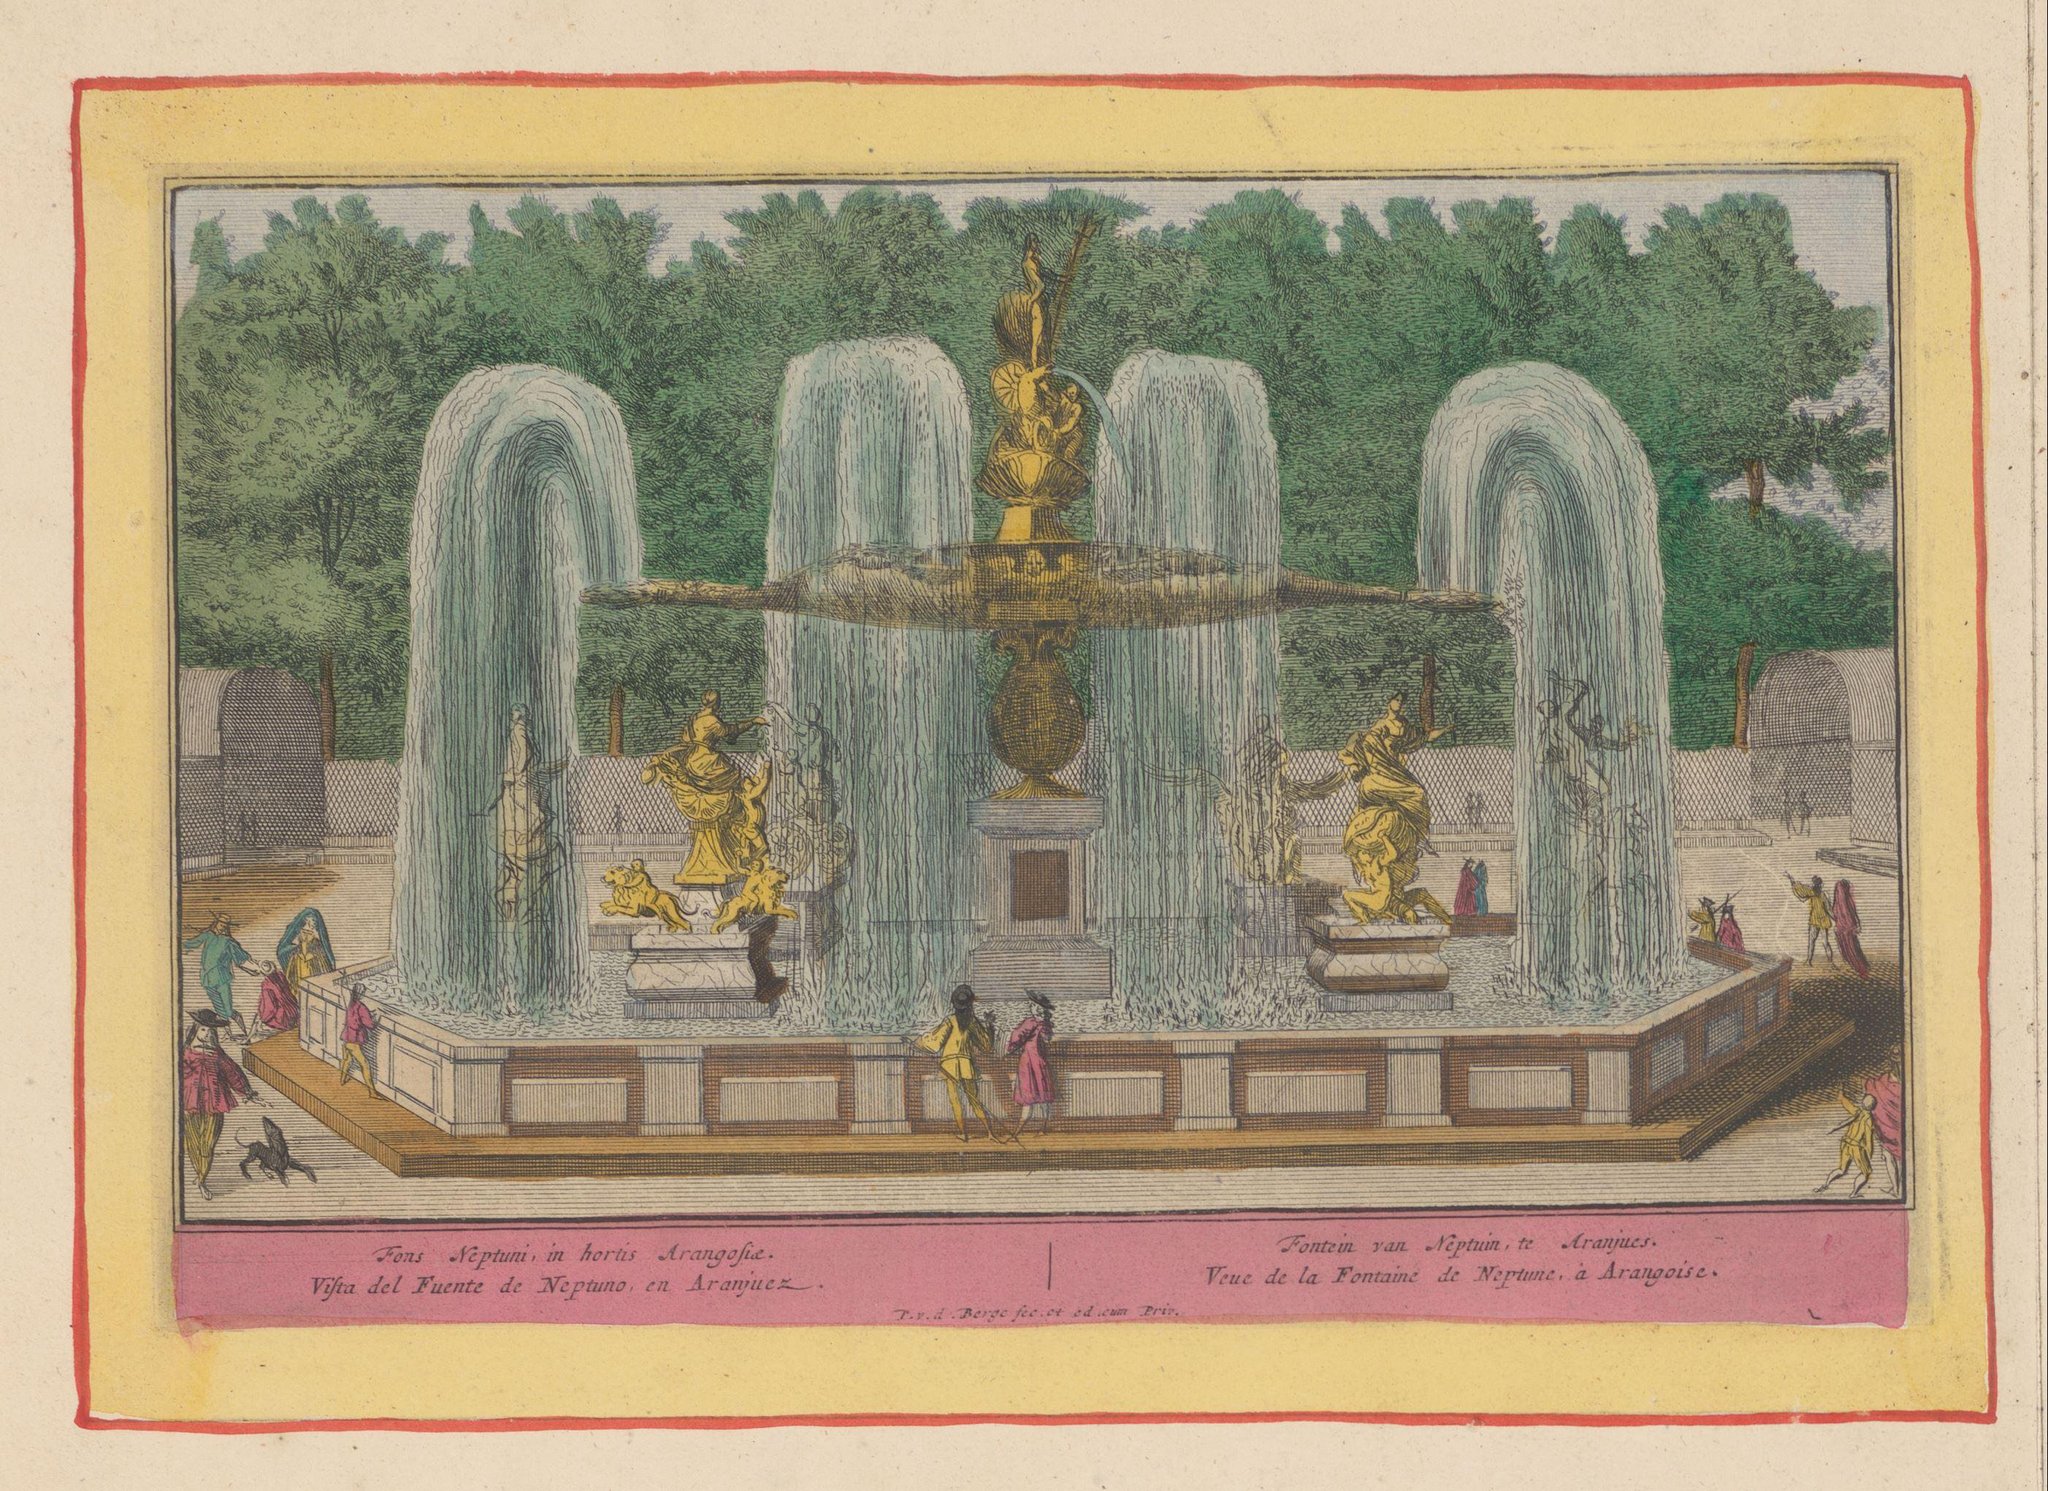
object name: print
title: Theatrum Hispaniae (...)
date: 1694-1737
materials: paper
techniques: etching, hand coloring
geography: the hague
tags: ornamental fountain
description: Prent uit: Theatrum Hispaniæ, exhibens regni urbes, villas ac viridaria magis illustria. Het aanmerkelykste en voortreffelykste in Spanjen (...). Amsterdam: Pieter van den Berge, ca. 1694-1737.